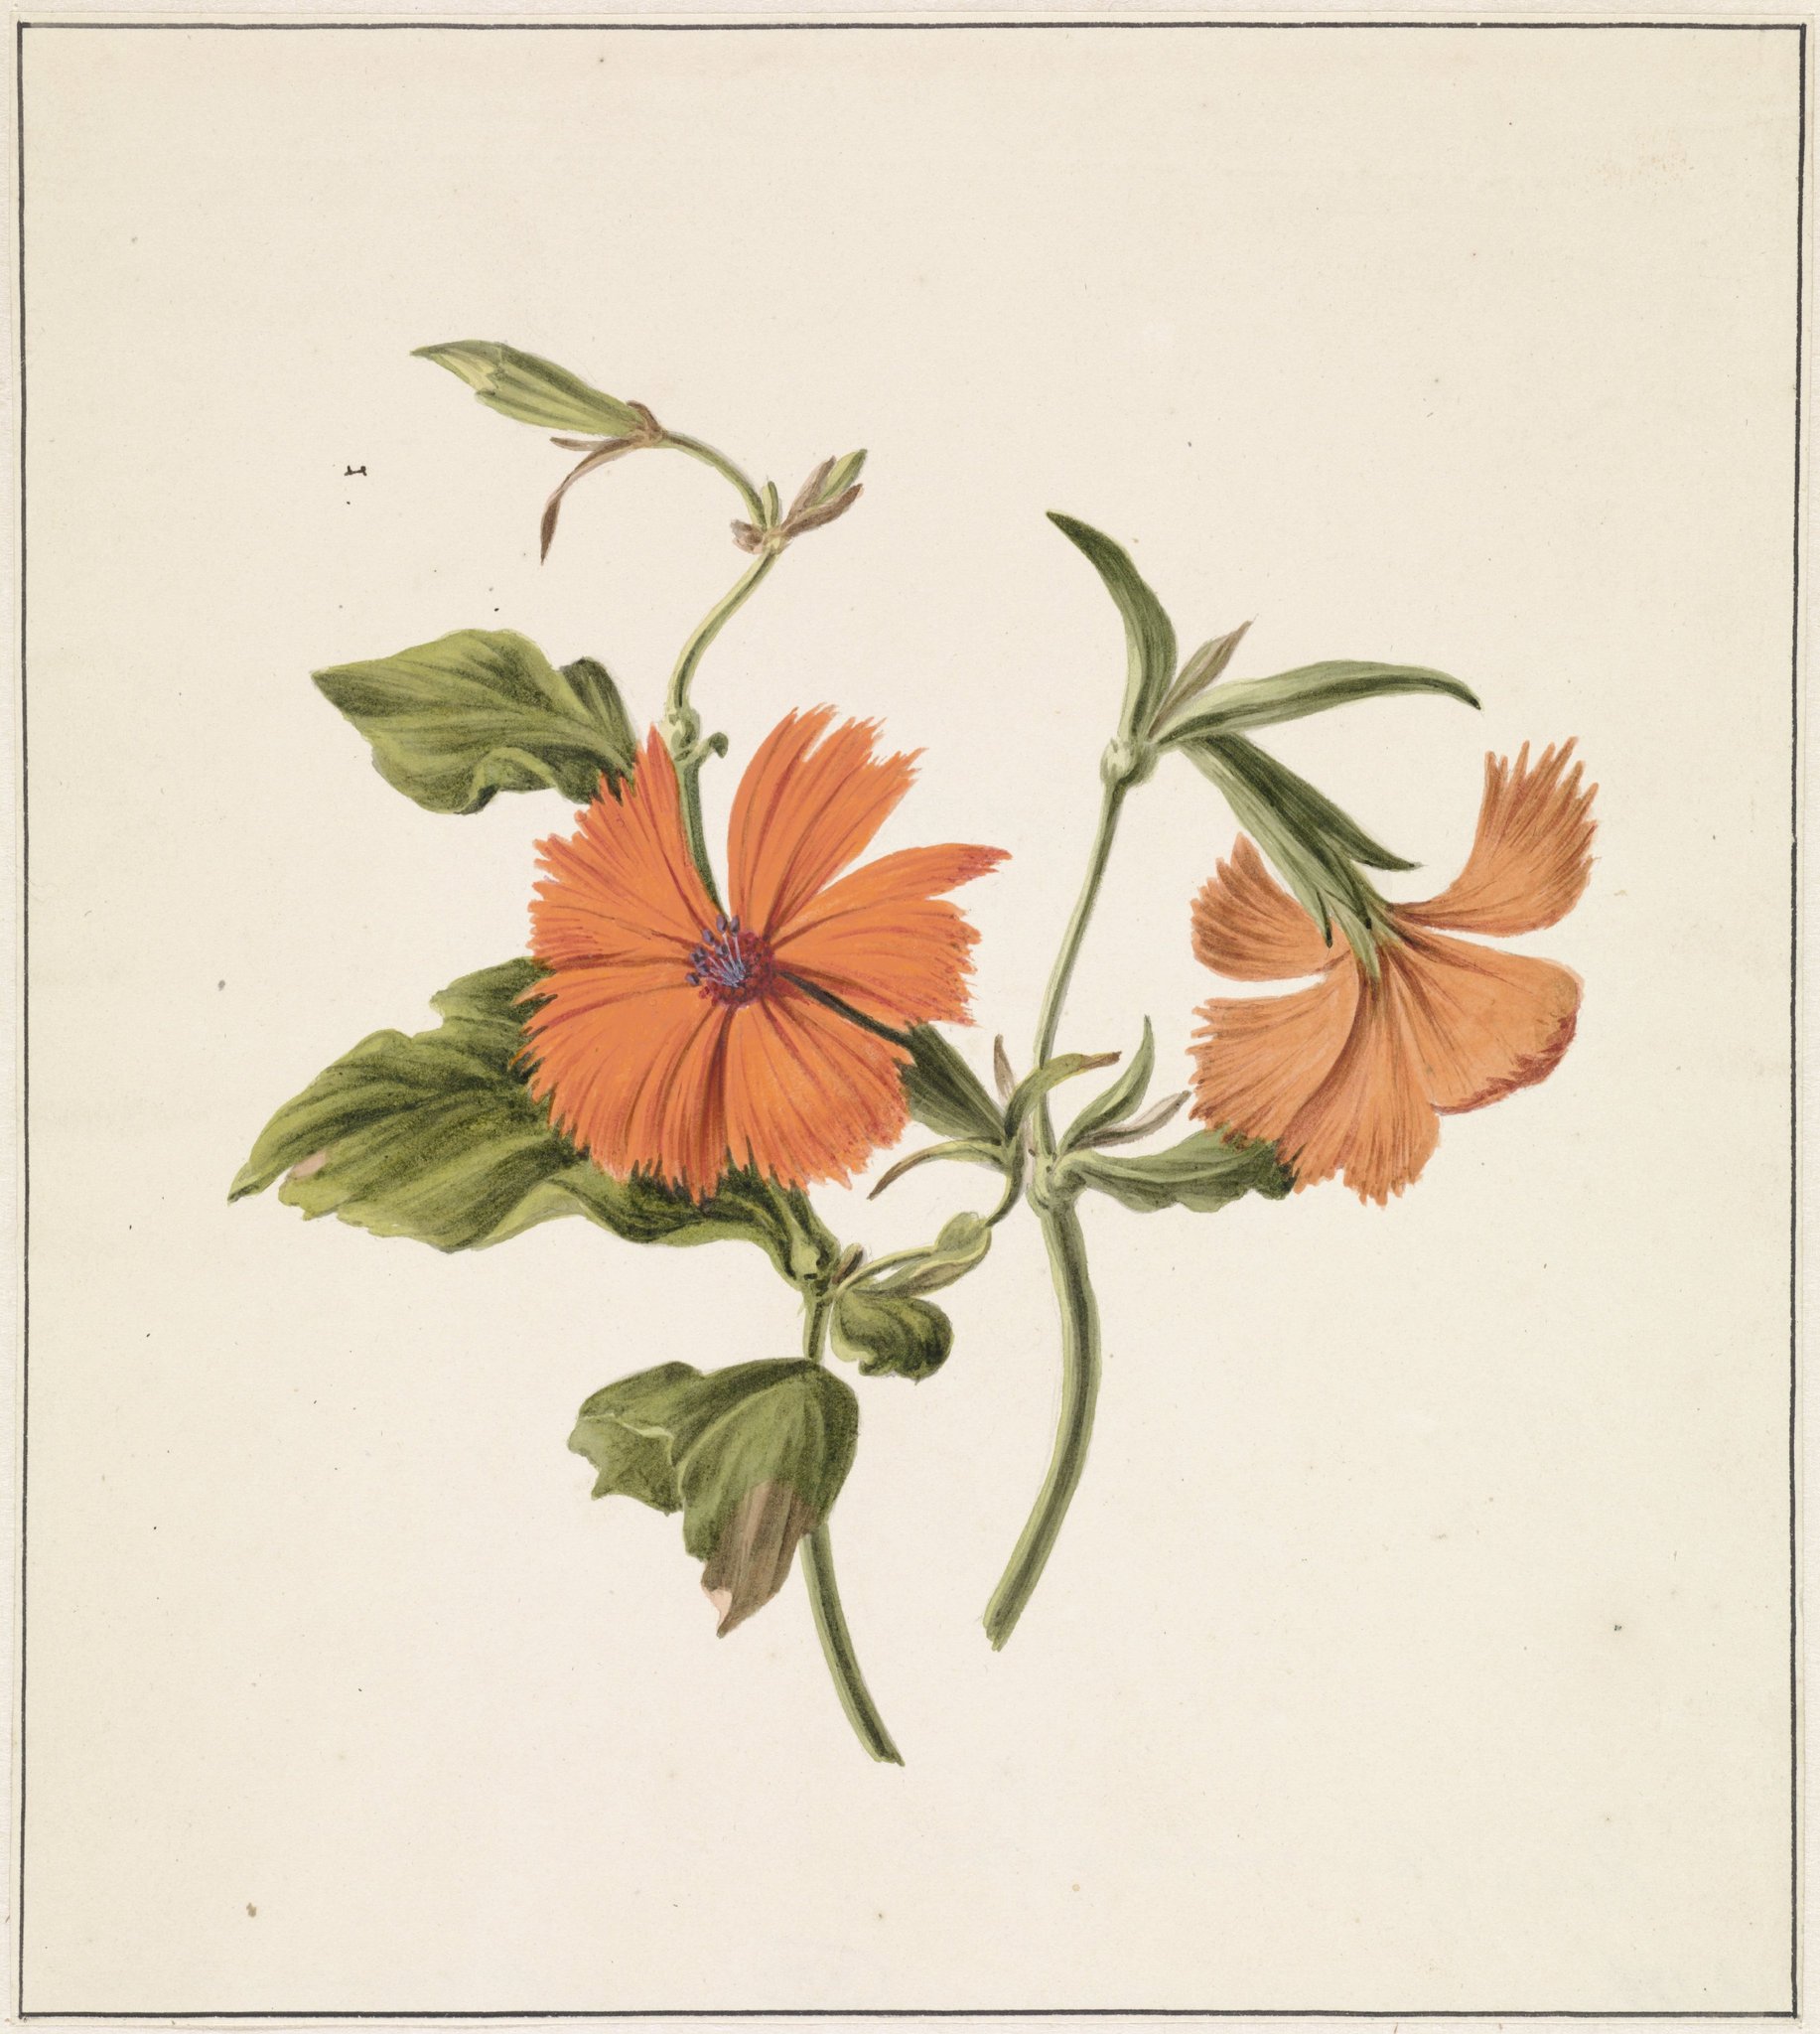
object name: drawing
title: Gele Chinese roos (Rosa Chinensis Lutea)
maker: m. de gijselaar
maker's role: draughtsman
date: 1808-1820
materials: paper, watercolor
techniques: brush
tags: flowers